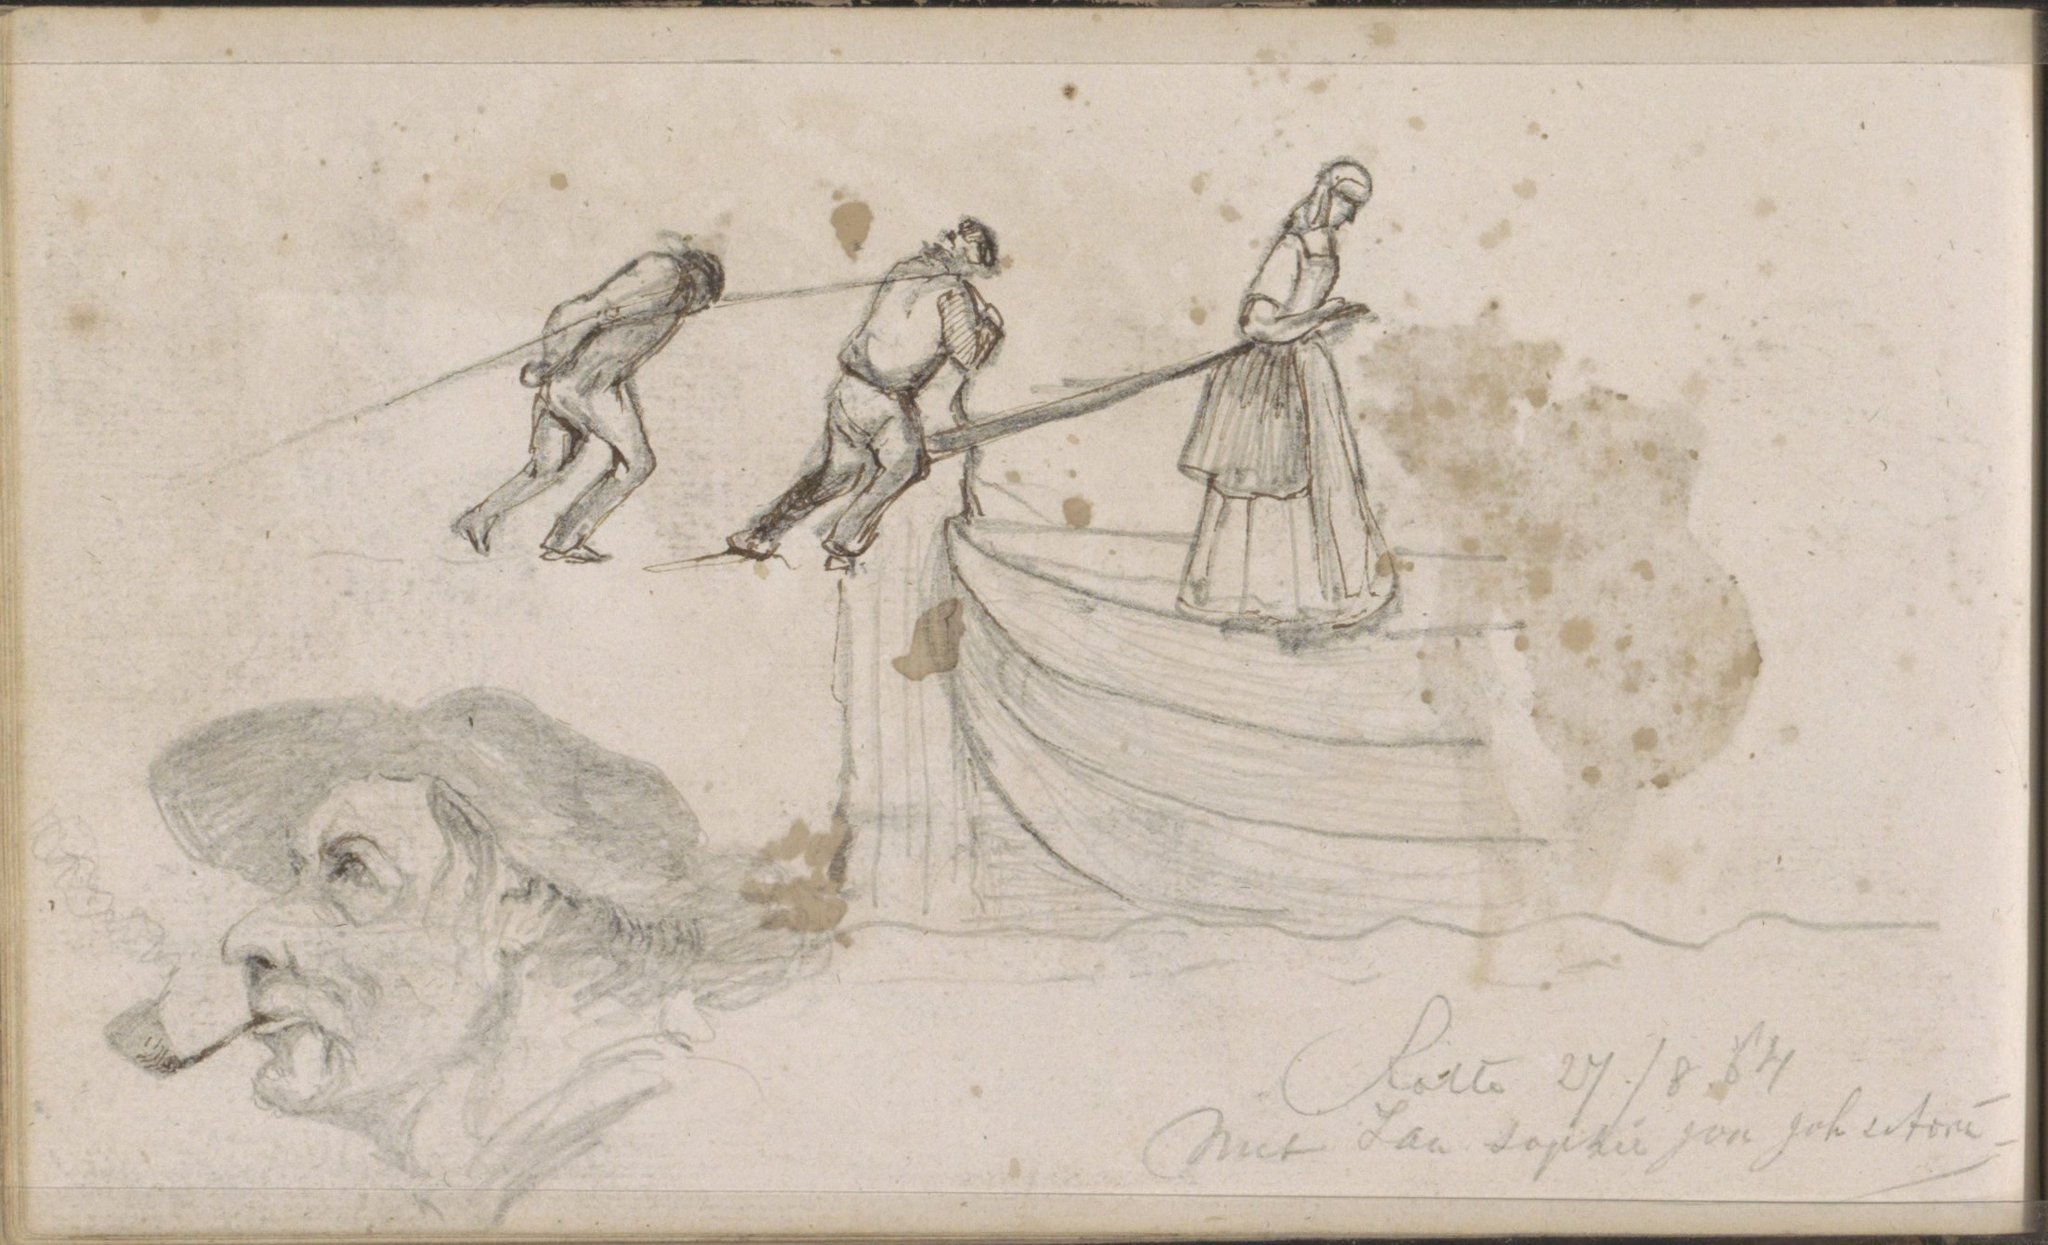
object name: sketchbook leaf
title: Studieblad, onder andere met een kop van een pijprokende man en deel van een boot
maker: johannes tavenraat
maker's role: draughtsman, painter, print maker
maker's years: 1809-1881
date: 1808-1864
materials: ink, paper, pencil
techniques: pen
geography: rotterdam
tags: drawing, pulling something, head (human), adult man, pipe ~ tobacco, farmers - aa - female farmer, farmer's wife, rowing-boat, canoe, etc.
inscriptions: date and inscription: ‘Rotte 27/8 64- met Jan sophie [...]’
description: Tevens studies van een boerin en twee mannen die vermoedelijk een trekschuit (die niet is getekend) voorttrekken. Blad 53 verso uit een schetsboek met 98 bladen.